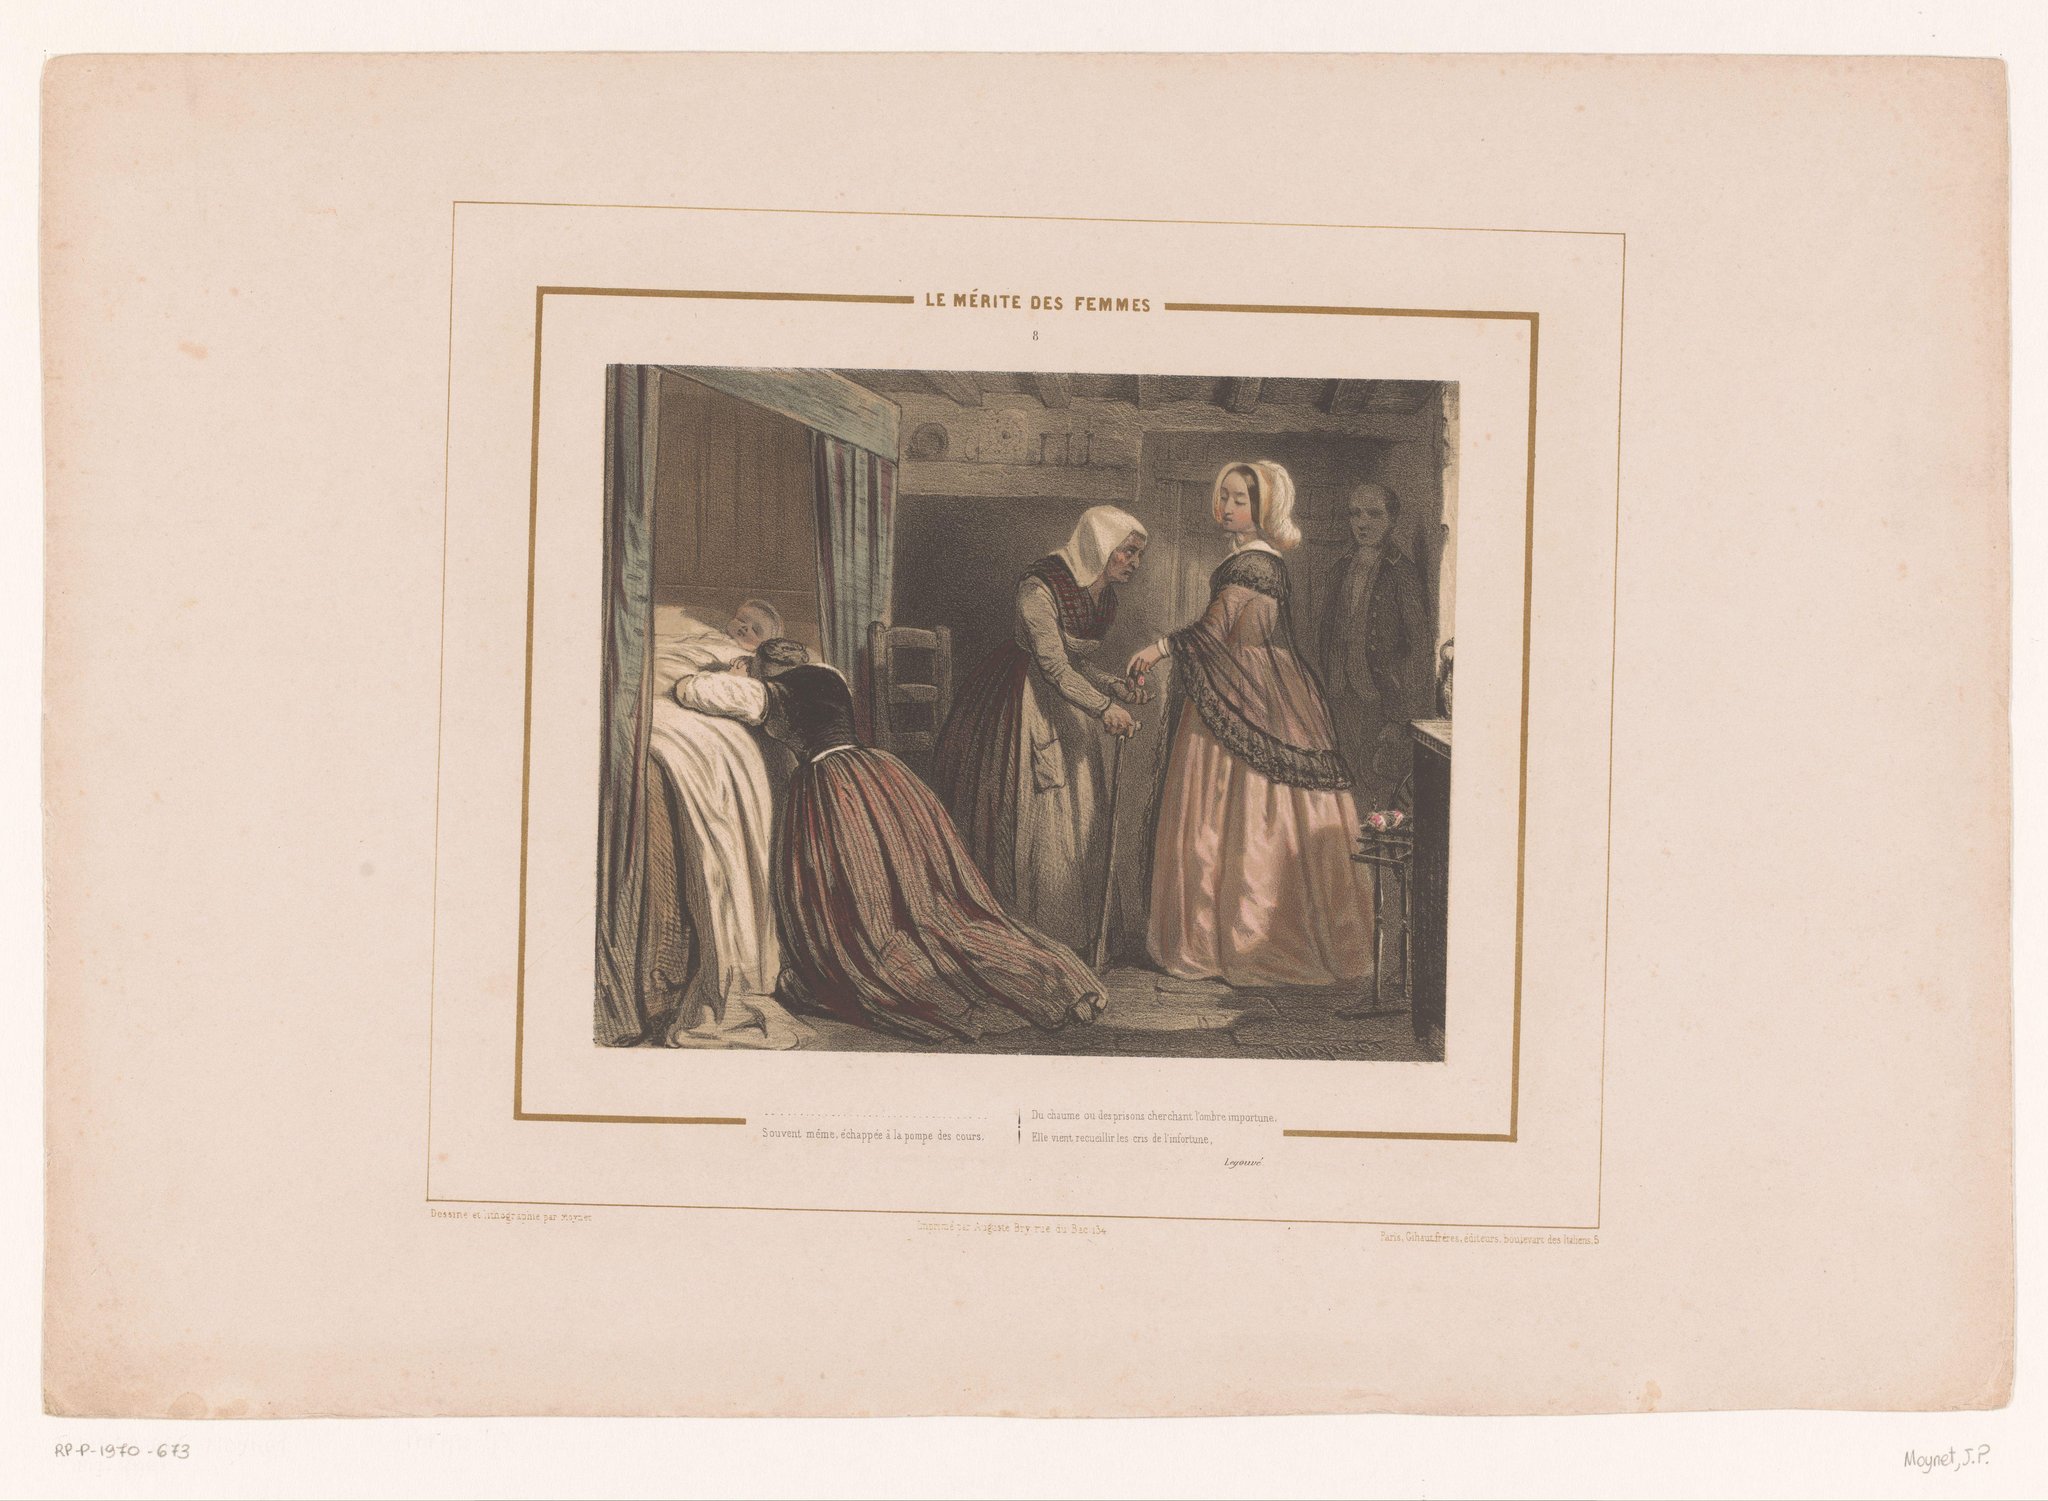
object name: print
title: Verdienste van de vrouw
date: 1831-1871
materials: paper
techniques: hand coloring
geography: paris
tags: patient, sick person, bed, infant, baby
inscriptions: inscription: ‘v. Stockum, 24 Nov. 1964/ No. 172 (81 st.) f. 520-’, collector's mark: Lugt 2228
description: Onder een deel van het gedicht 'Le mérite des femmes' van Gabriel-Marie Legouvé: Souvent même, échappée à la pompe des cours, Du chaume ou des prisons cherchant l'ombre importune, Elle eniet recueillir les cris de l'infortune,.